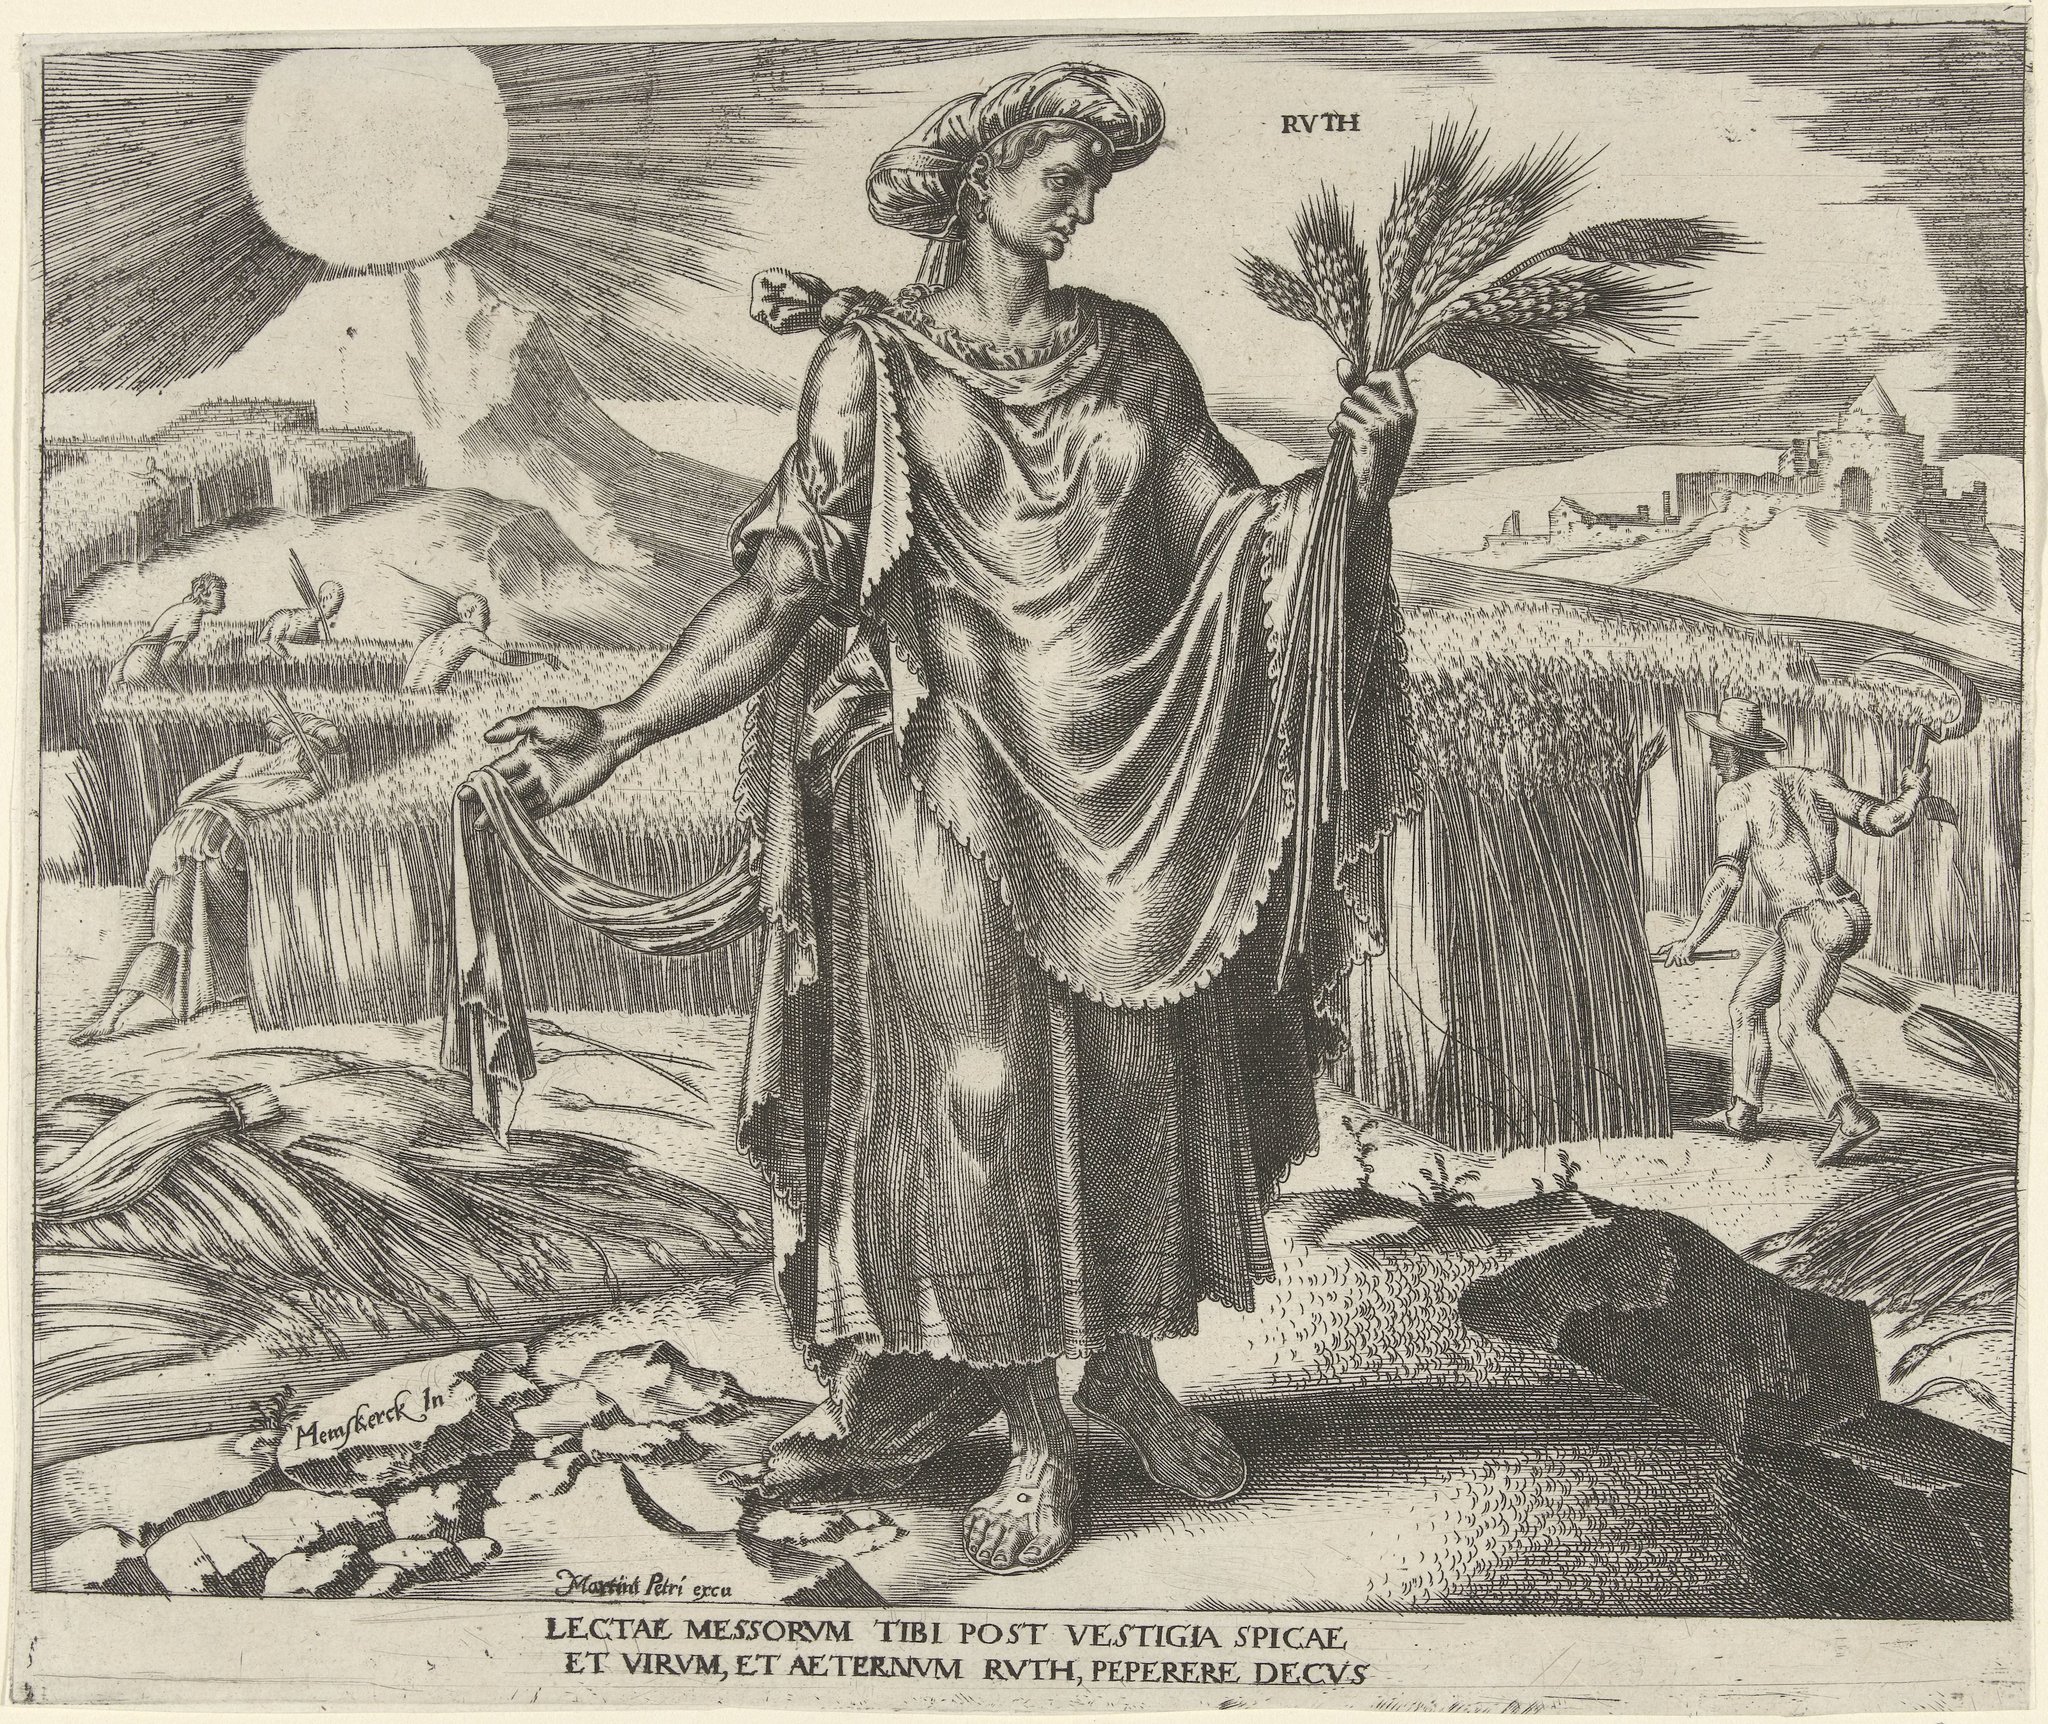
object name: print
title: Acht beroemde vrouwen uit het Oude en Nieuwe Testament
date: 1560-1570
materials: paper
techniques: engraving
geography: antwerp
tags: female persons from the old testament (with name) (not in biblical context)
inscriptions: collector's mark: Lugt 2228, collector's mark: Lugt 2760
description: Ruth staat met korenaren in de linkerhand. Op de achtergrond de korenoogst en het arenlezen. Tweede prent uit een serie van acht prenten met beroemde vrouwen uit het Oude en Nieuwe Testament.